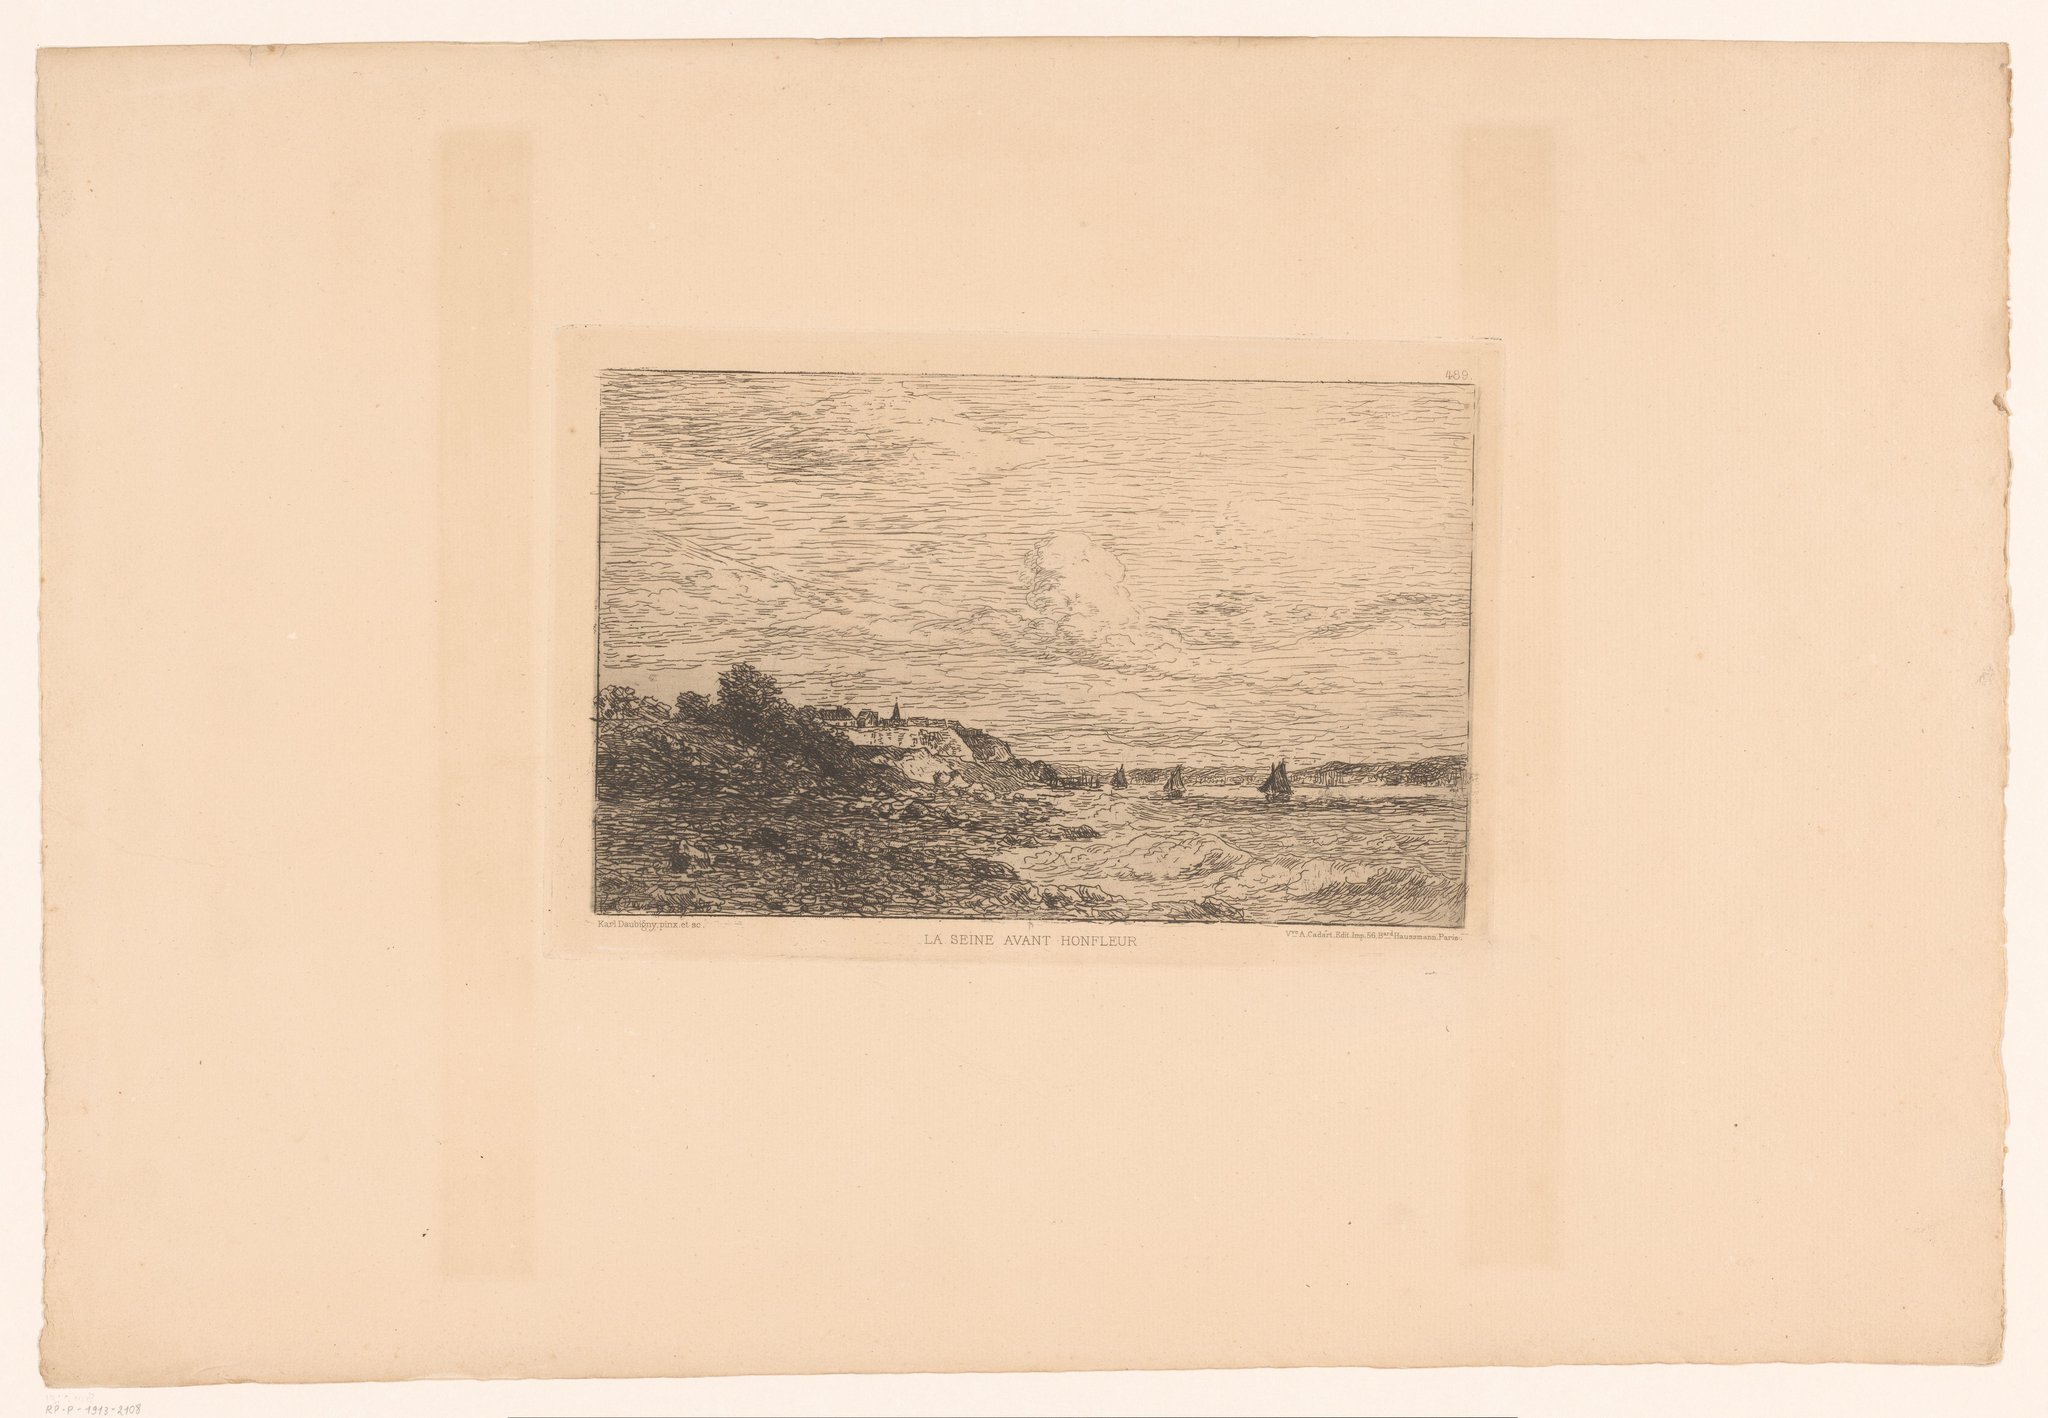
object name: print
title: La Seine avant Honfleur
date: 1875-1886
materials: paper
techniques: drypoint, etching, roulette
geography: paris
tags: landscapes, river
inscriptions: collector's mark: Lugt 2233